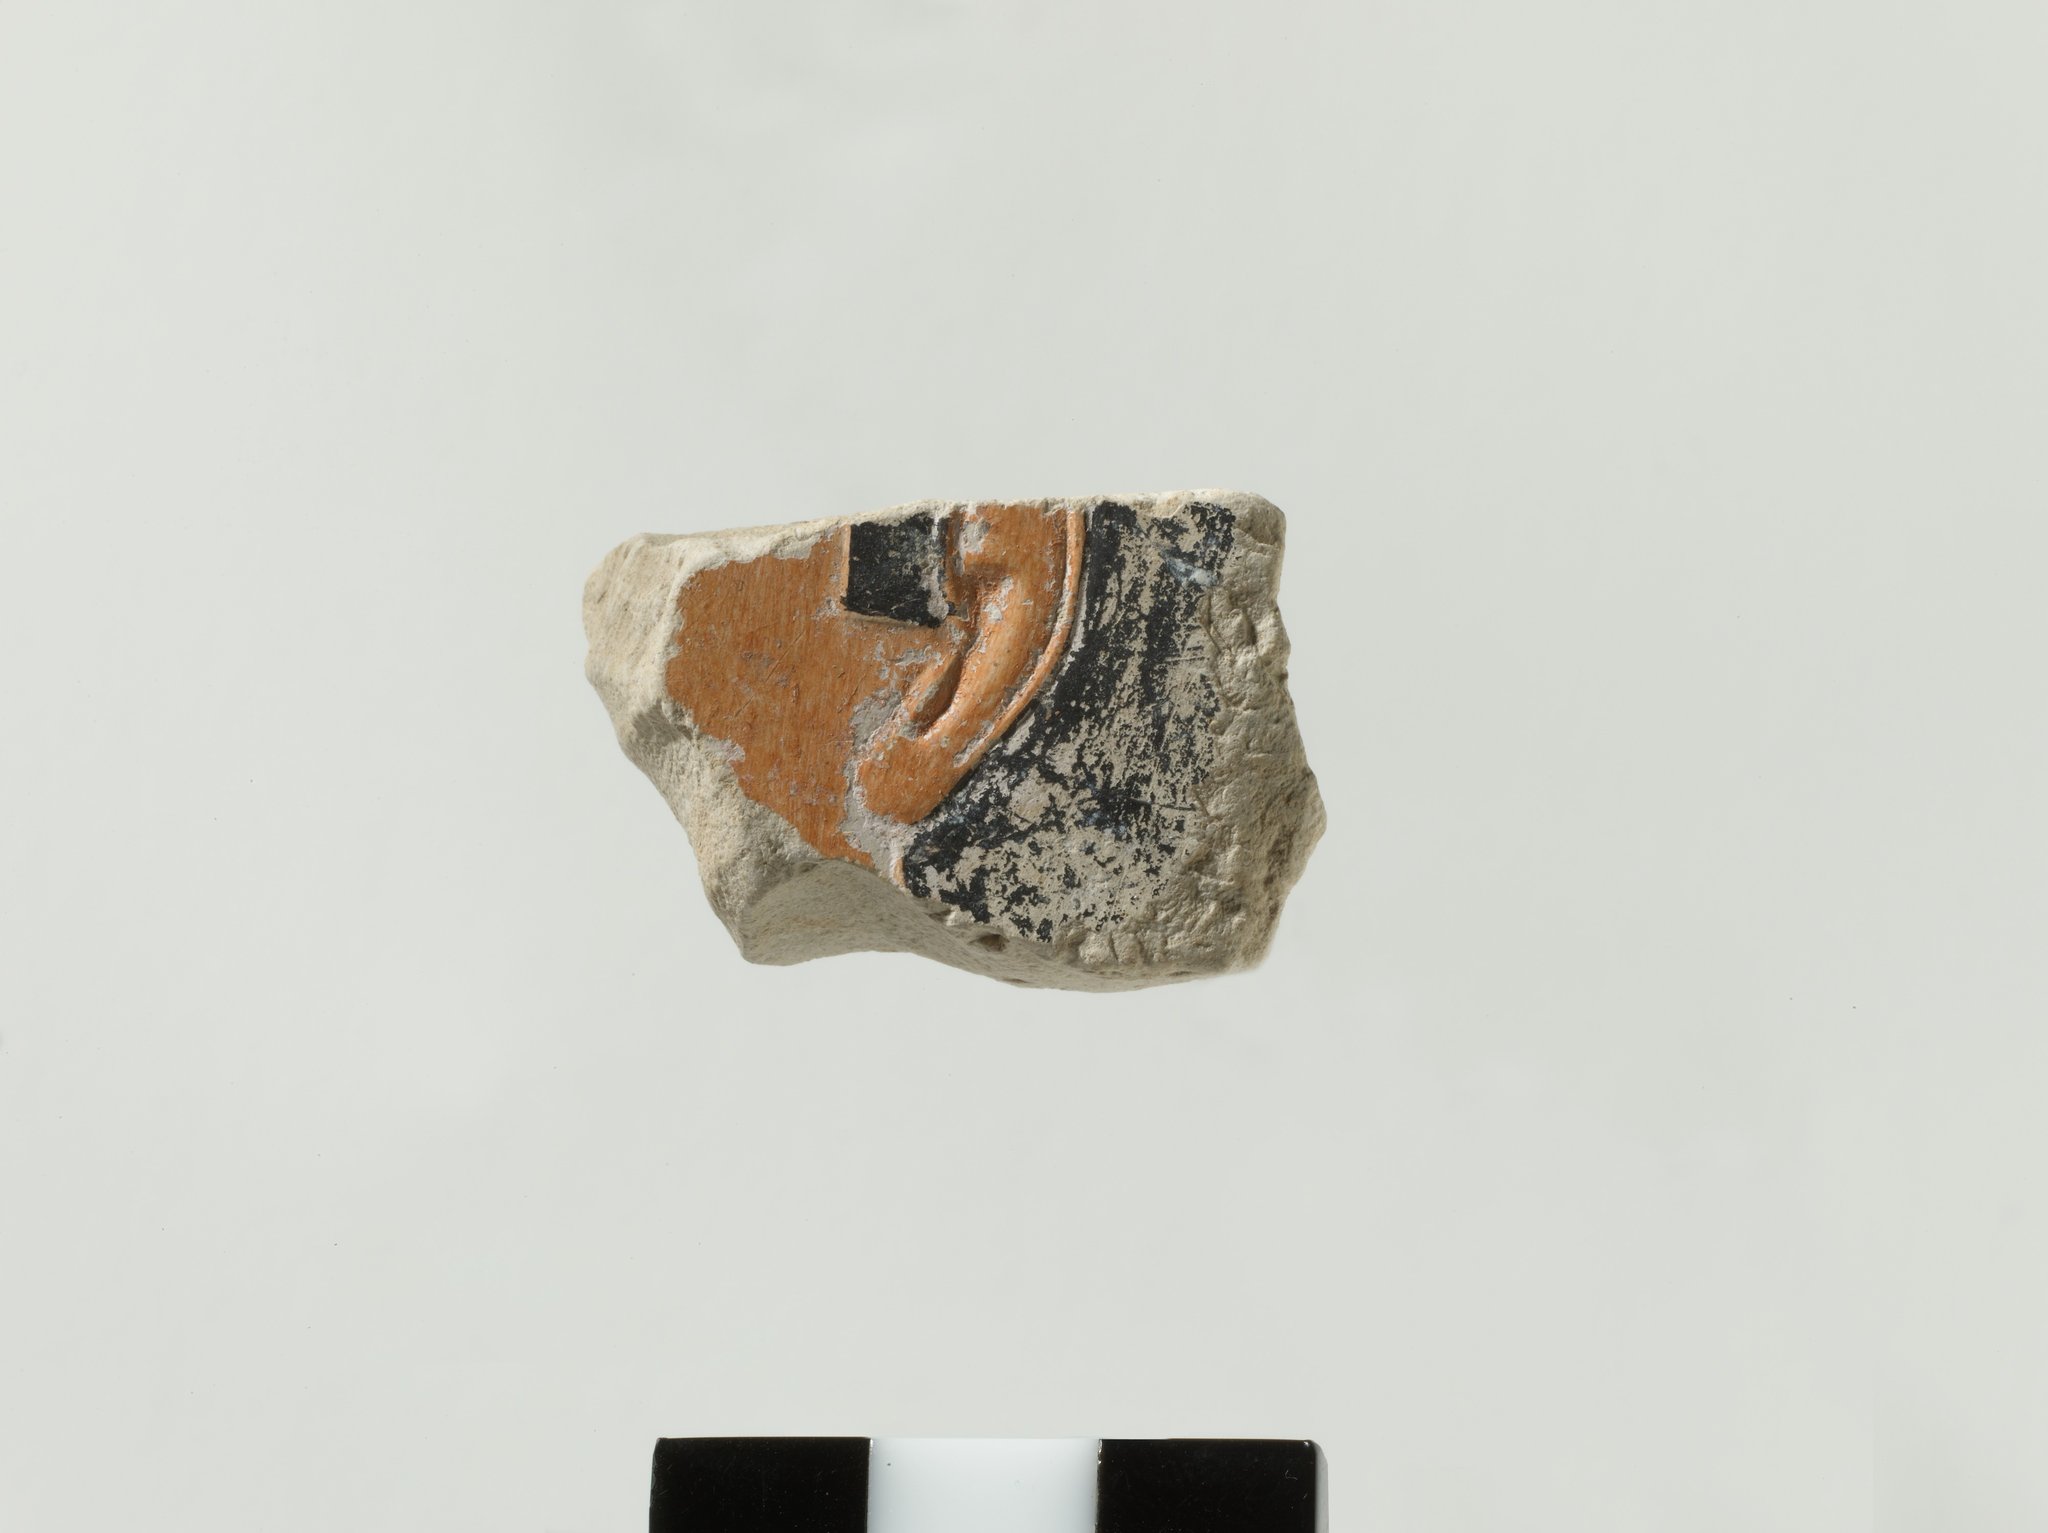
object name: relief fragment, tomb of meketre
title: Relief fragment from the tomb of Meketre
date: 1981-1975 BCE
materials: limestone, paint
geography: egypt